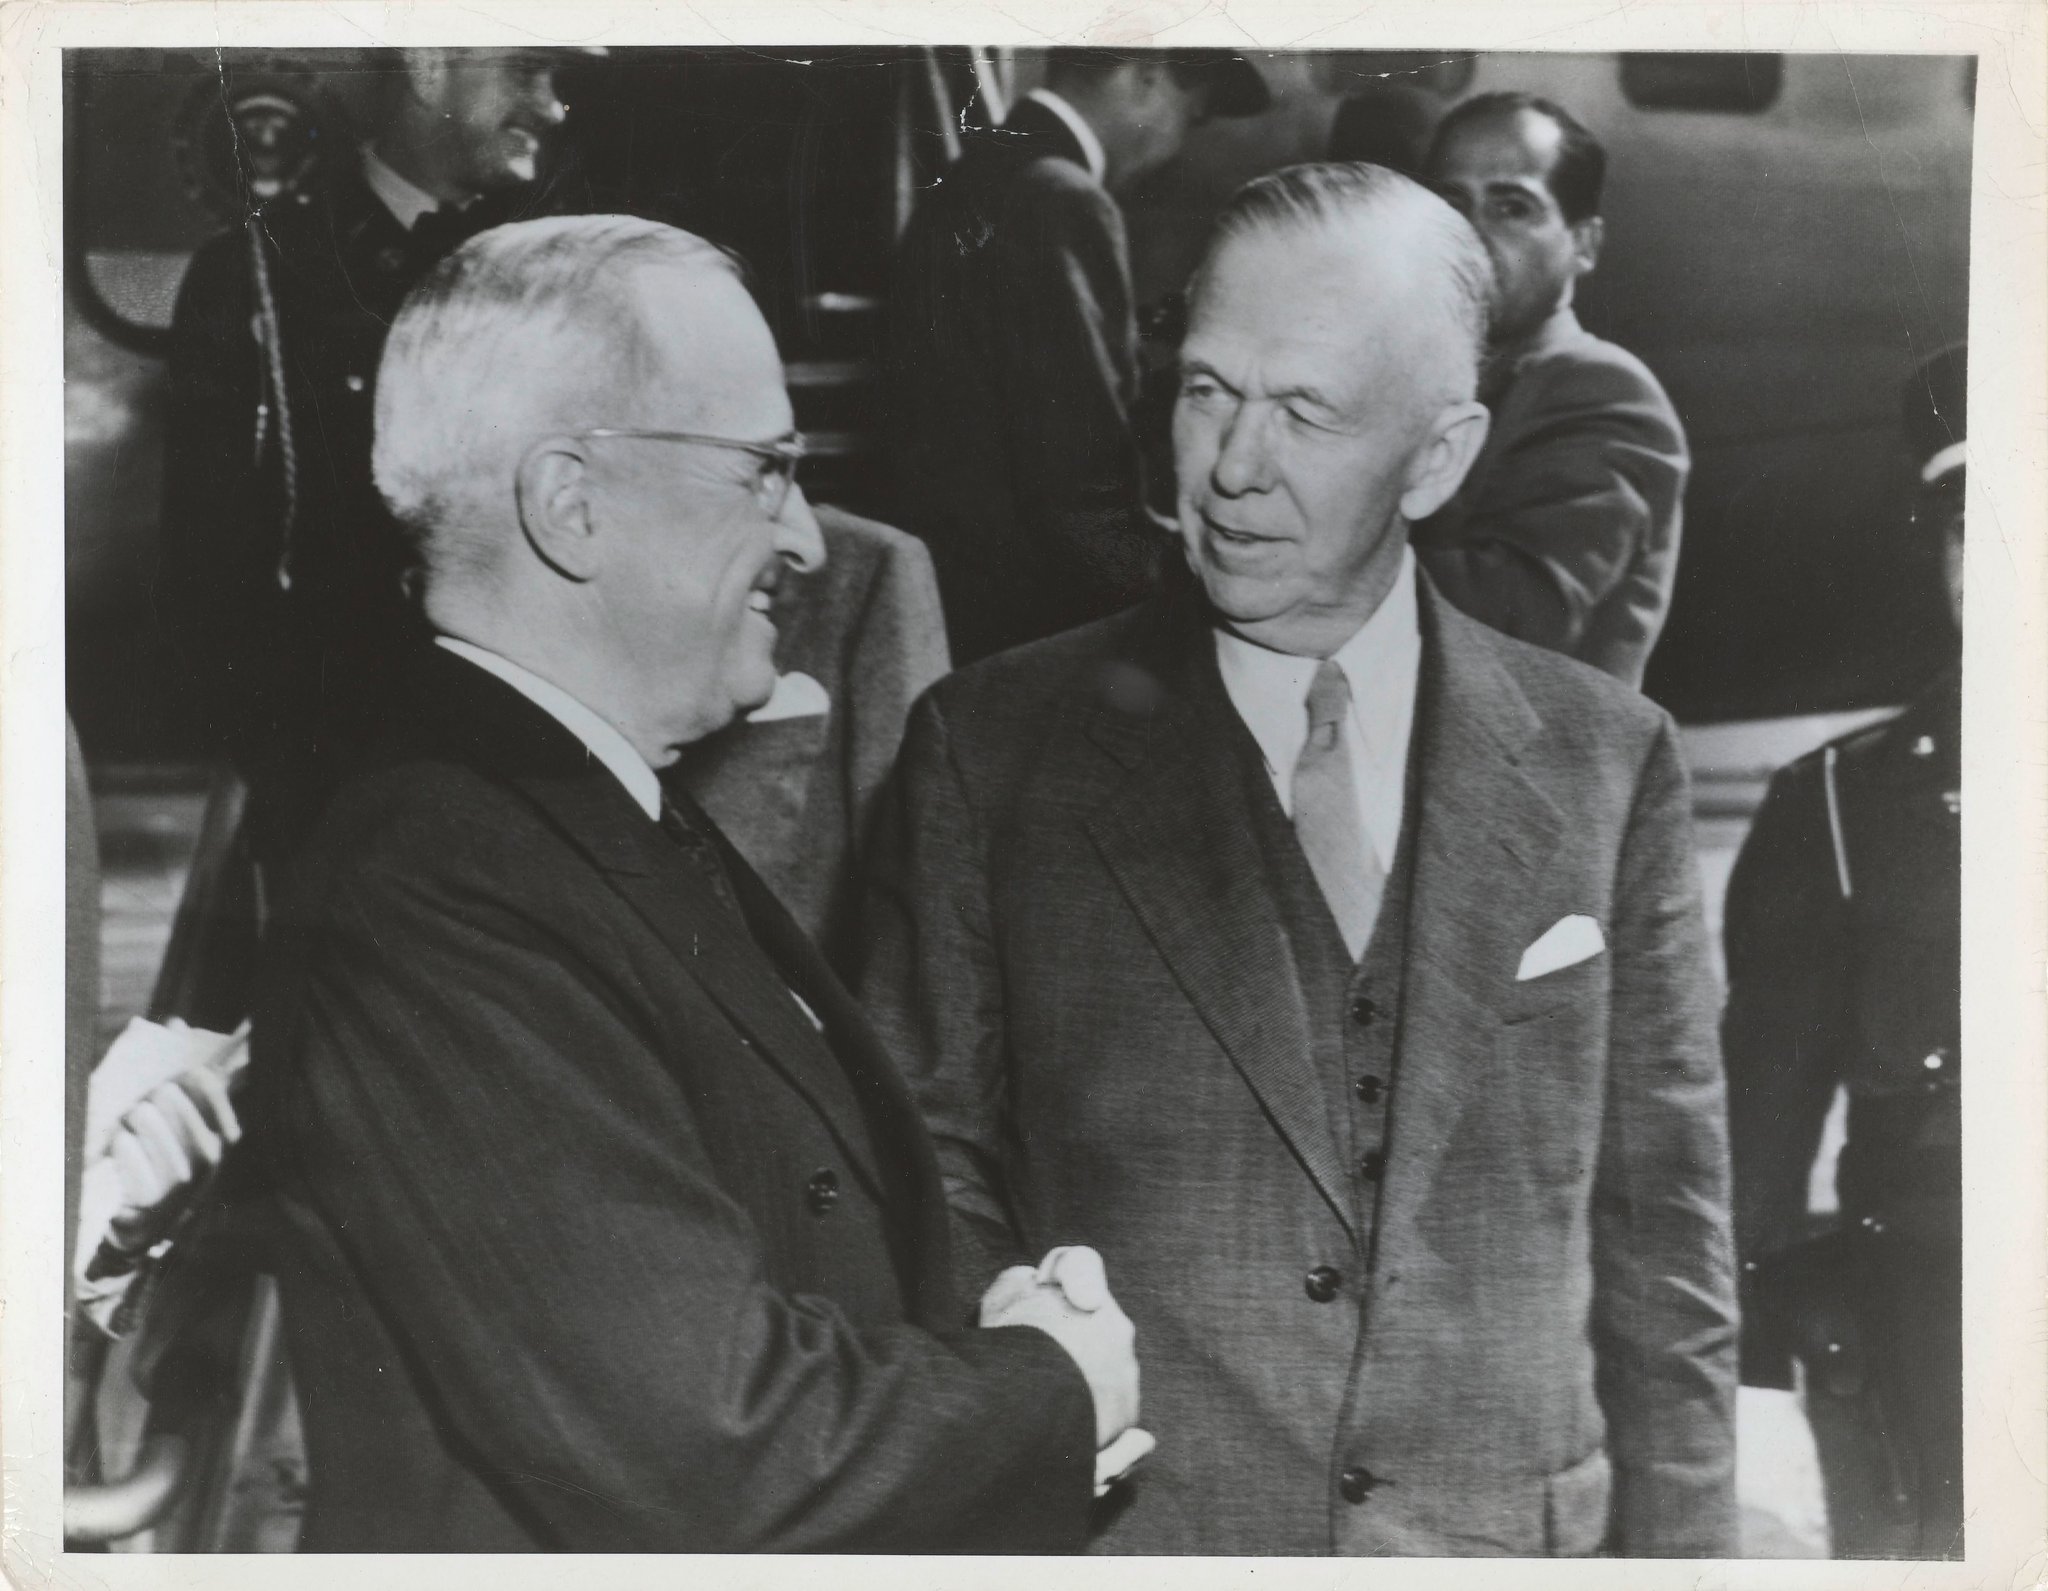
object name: photograph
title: President Truman en Secretary of State George Marshall, 1948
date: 1948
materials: photographic support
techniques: gelatin silver print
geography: new york city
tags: generaal, george c marshall, president, harry s. truman, washington d.c.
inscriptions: stamp: ‘N.V. Photo Press Belgium, Frankrijklei 108 - Antwerpen’, stamp: ‘International News Photo a unit of king features Synd. 235 East 45th street, New York, N.Y.’